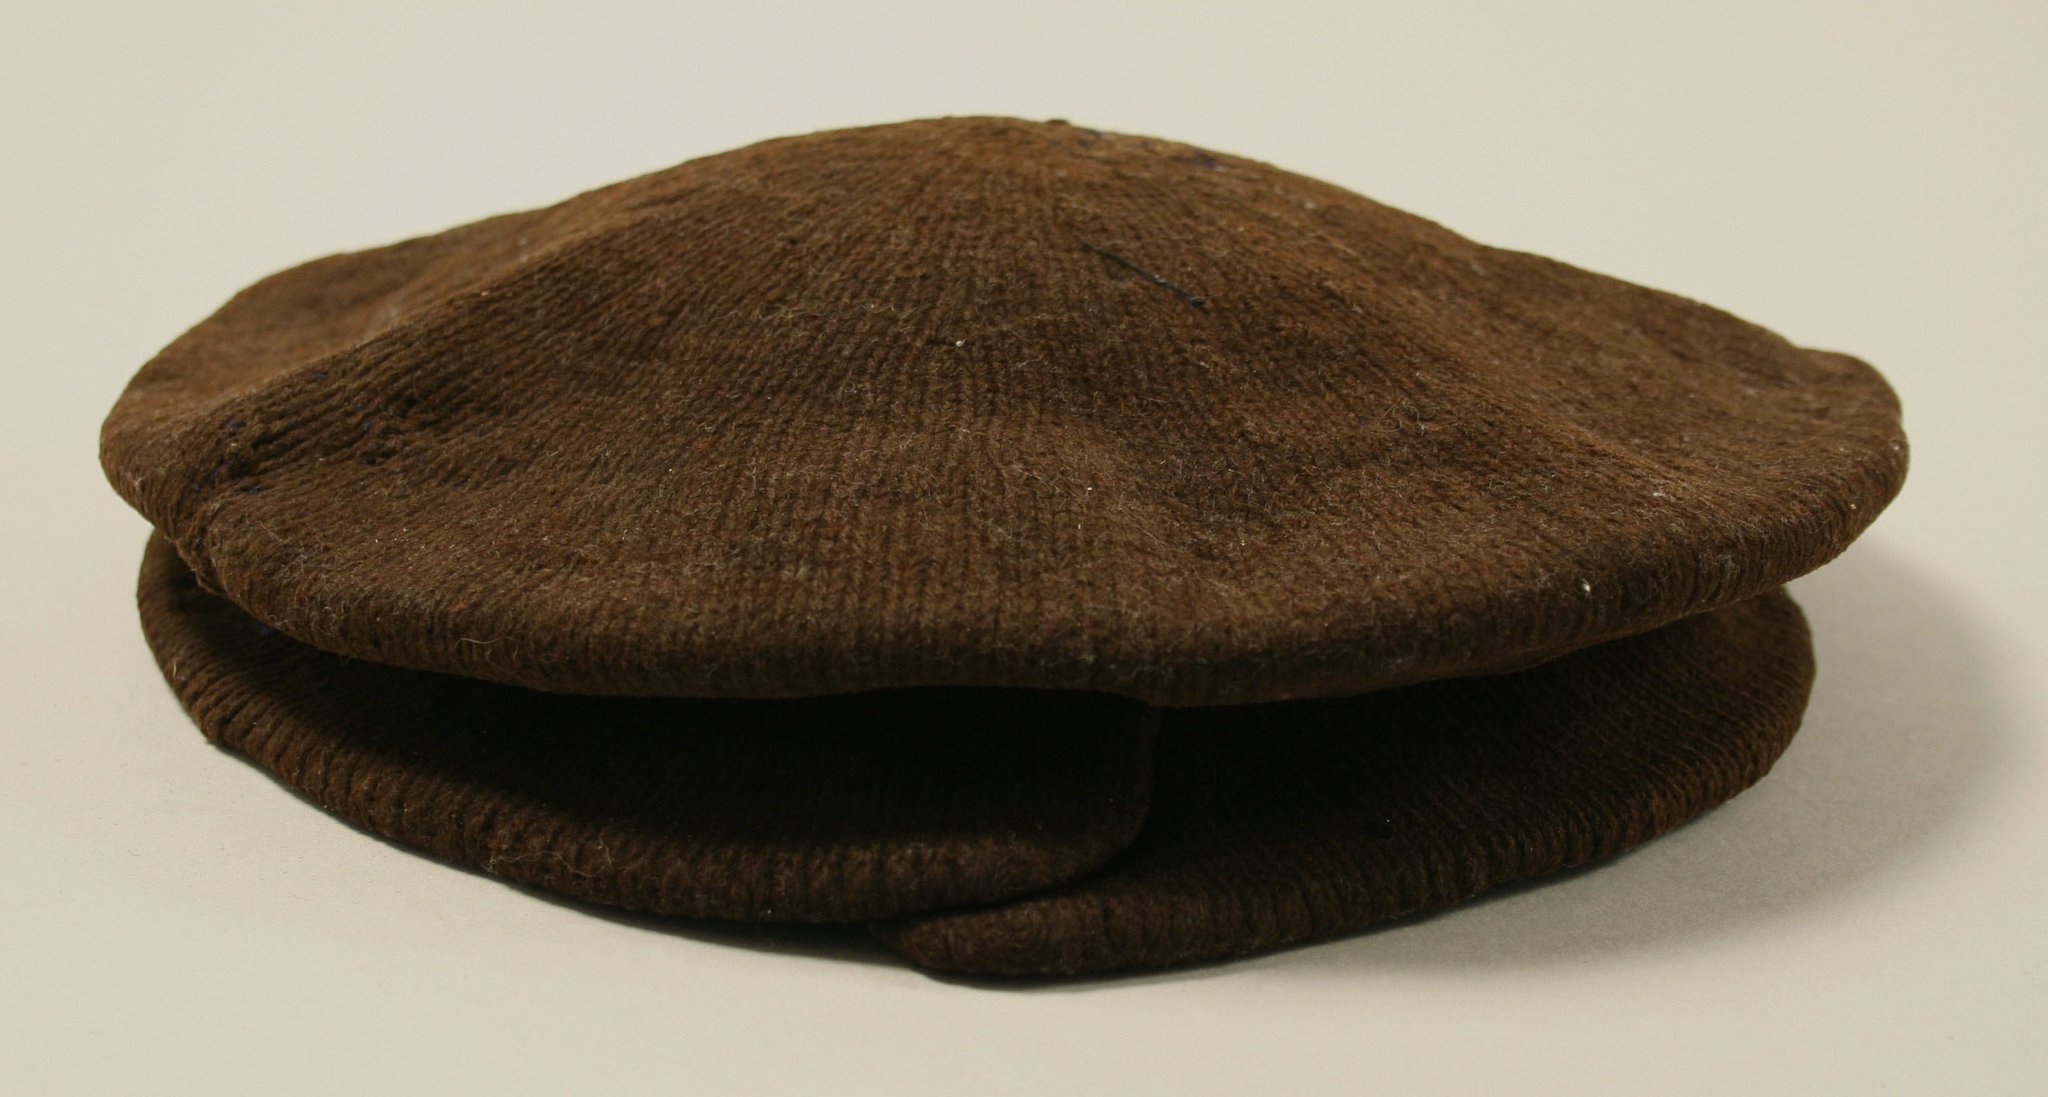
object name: cap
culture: british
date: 1501-1600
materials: wool